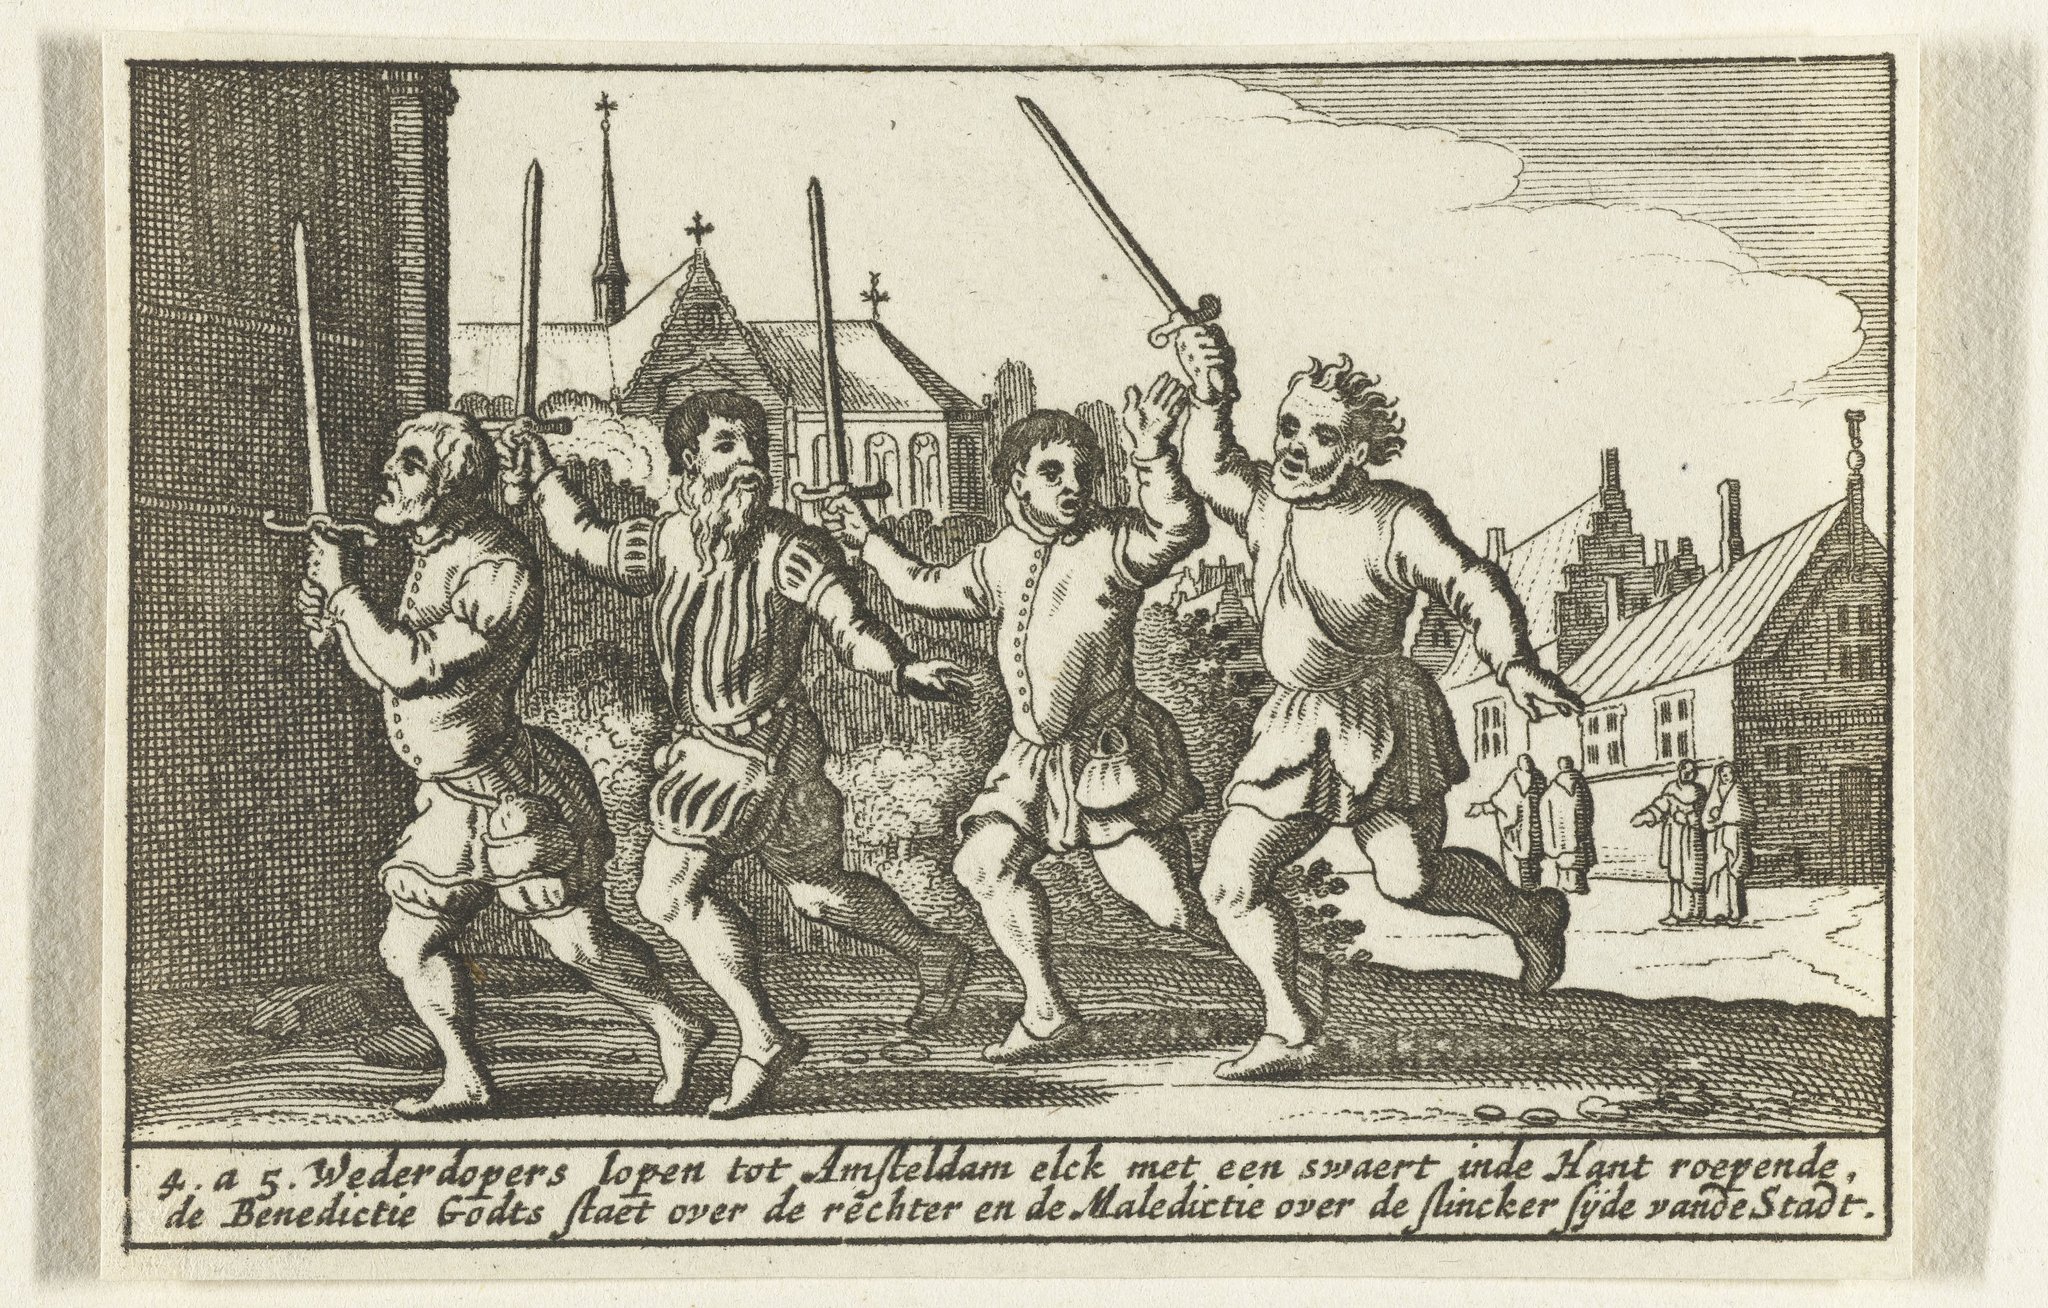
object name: print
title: Opstand van de wederdopers te Amsterdam in 1534-1535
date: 1629-1652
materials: paper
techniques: etching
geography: northern netherlands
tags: amsterdam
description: Deze prenten zijn gebaseerd op de oorspronkelijke anonieme gravures in de eerste uitgave L. Hortensius, Van den oproer der weder-dooperen, 1614. Alle 8 prenten op op één blad geplakt. Naar het verloren gegane schilderij van Barend Dircksz. in het oude stadhuis te Amsterdam.